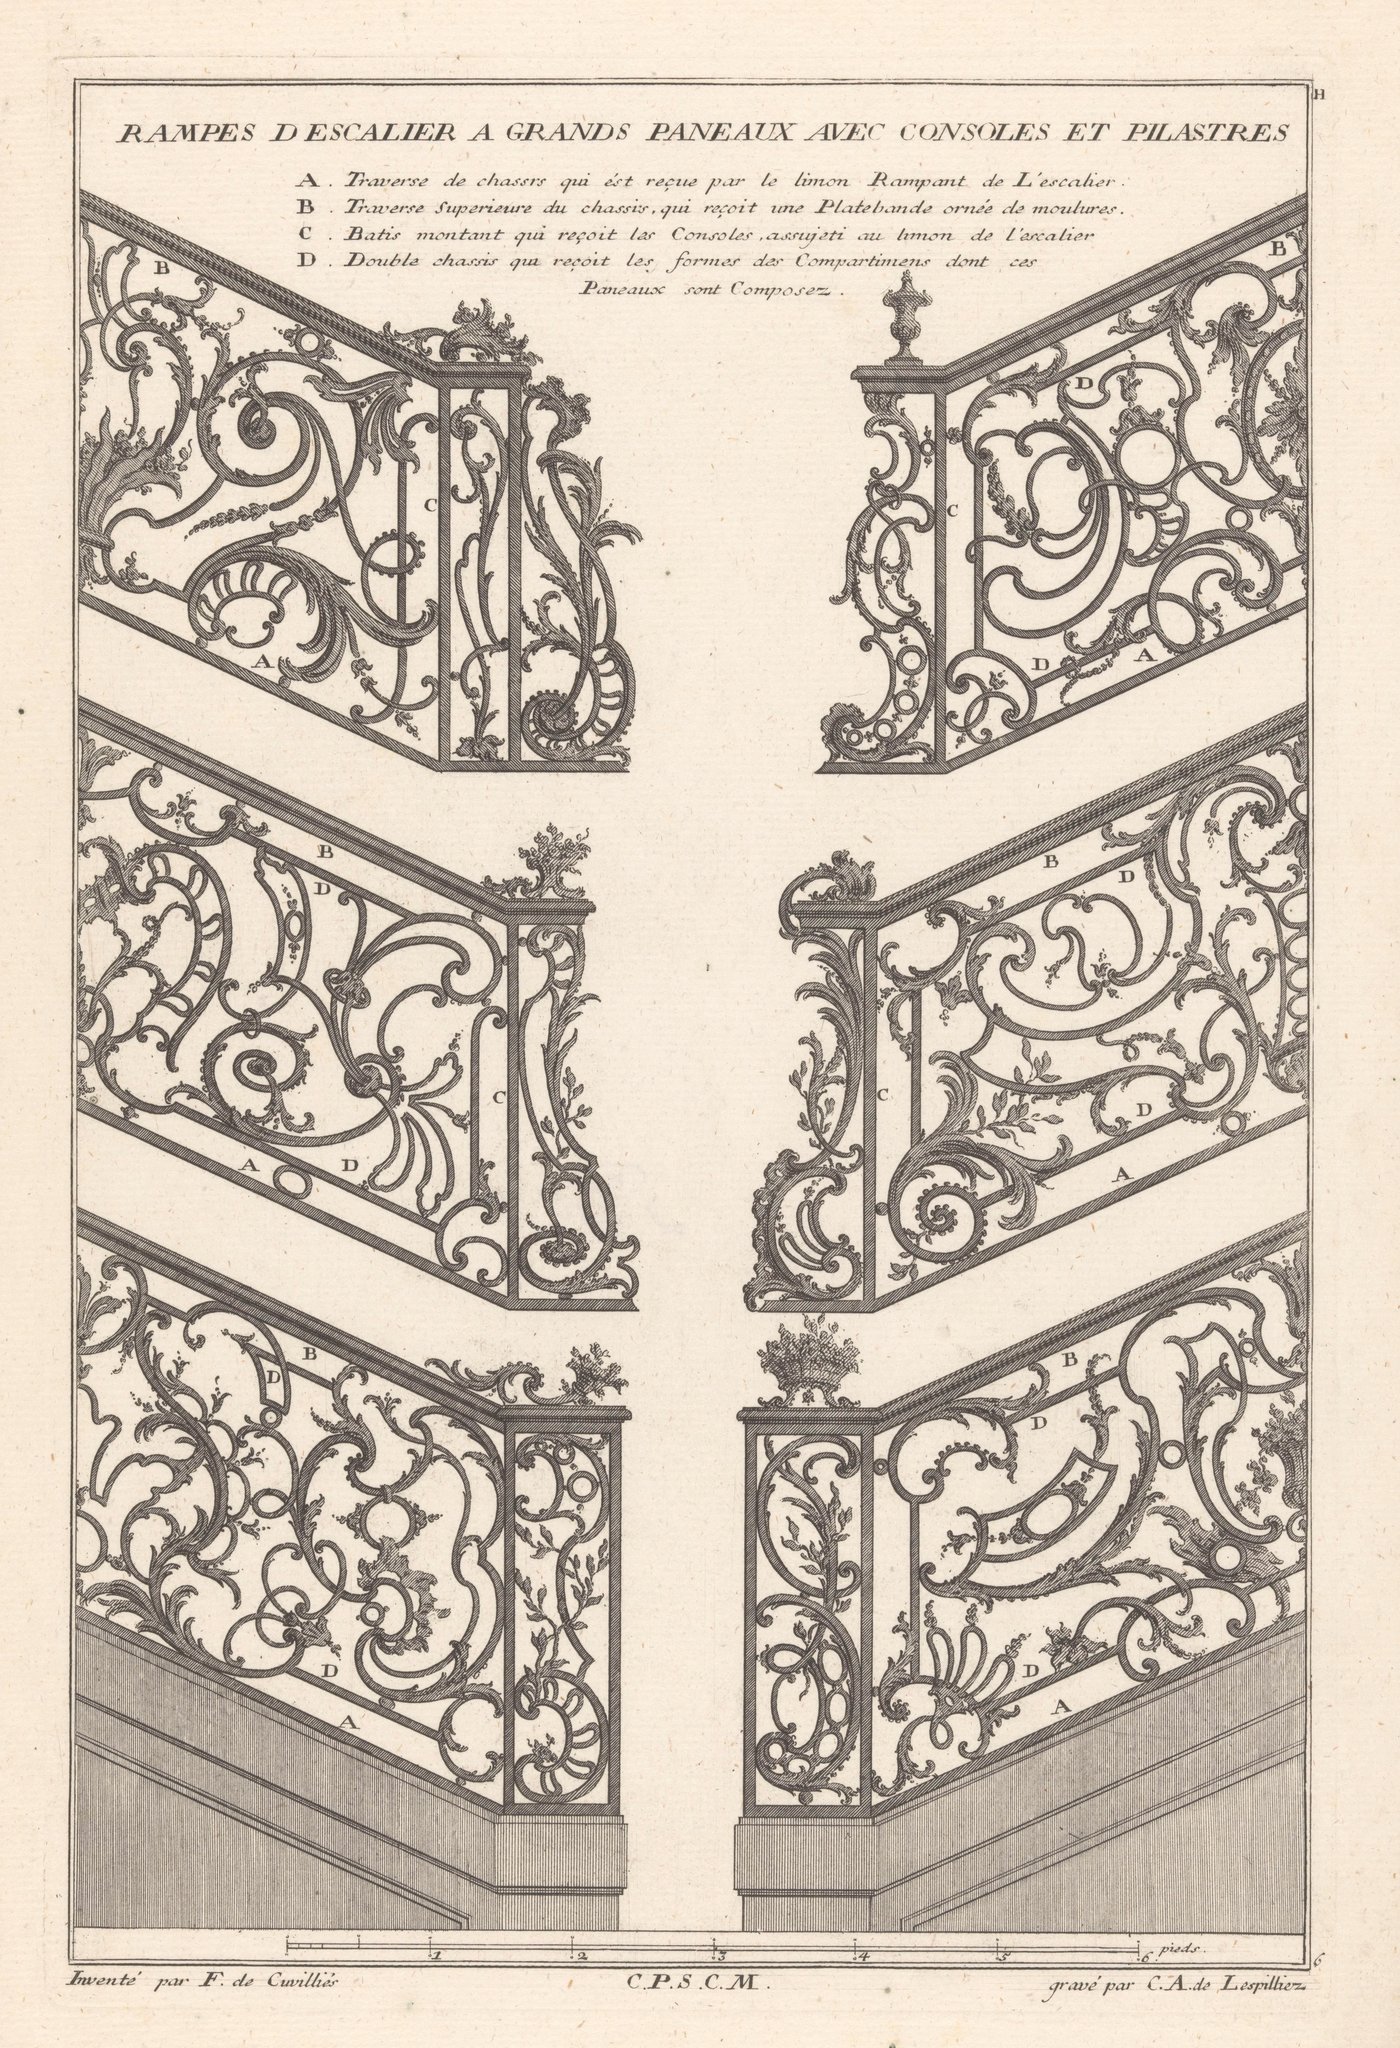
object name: ornament print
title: Smeedwerk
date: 1745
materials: paper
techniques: engraving, etching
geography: germany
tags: staircase, forging (industrial process)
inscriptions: collector's mark: Lugt 2228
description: Zes geornamenteerde smeedijzeren traphekken, de onderste twee met pilasters.